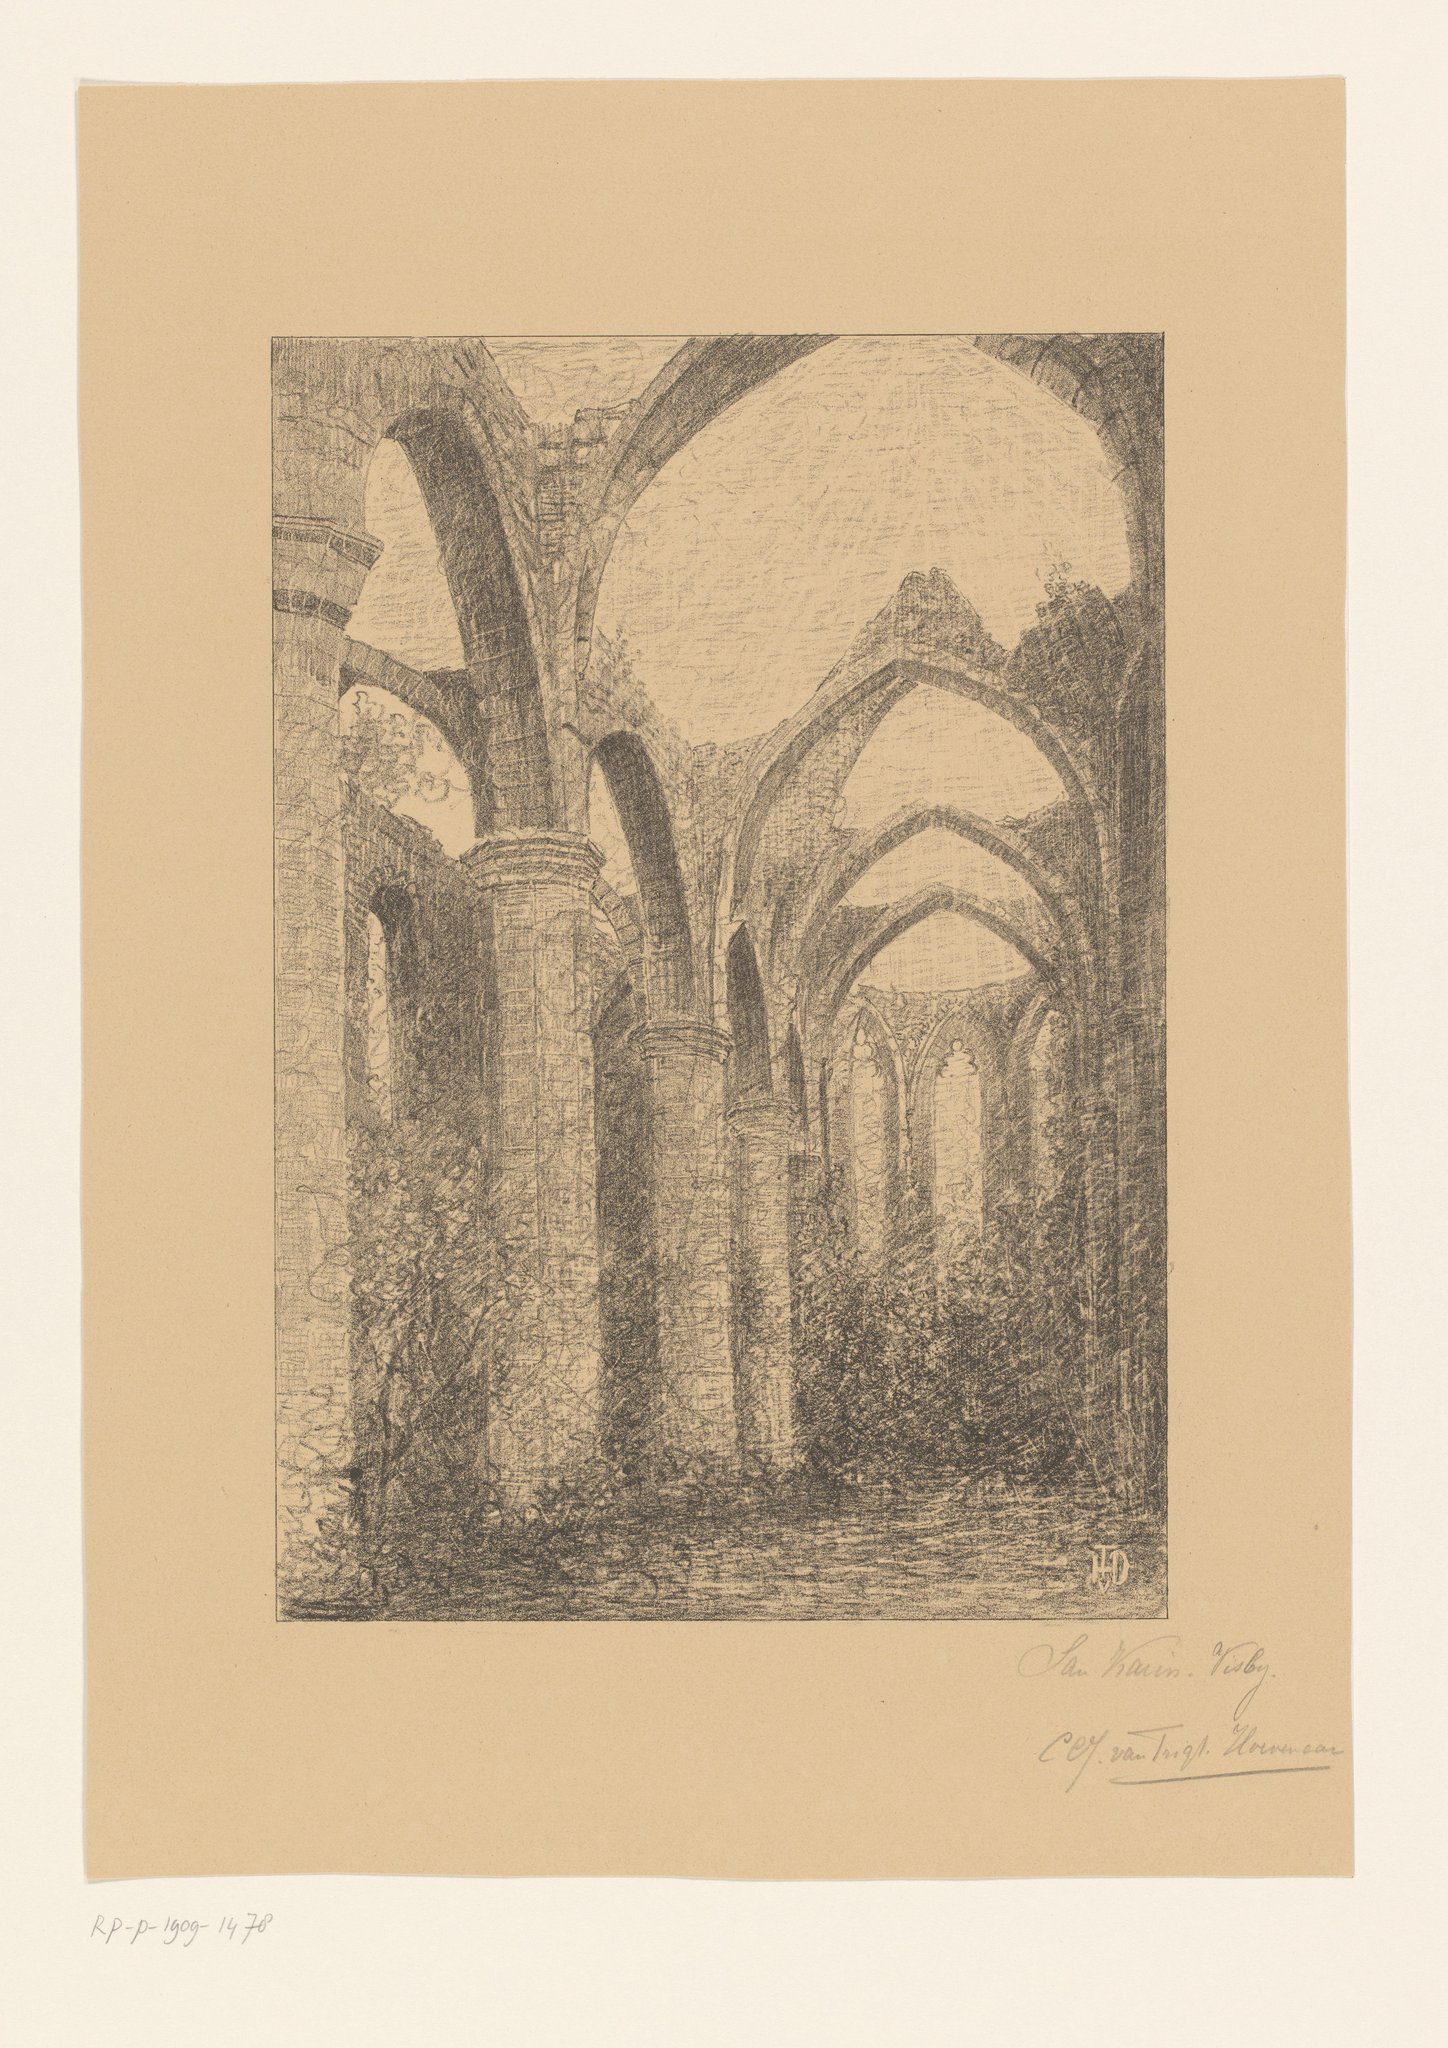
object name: print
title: Ruïne van San Karin op Visby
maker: cornelia christina johanna van trigt-hoevenaar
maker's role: print maker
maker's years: 1854-1924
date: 1864-1909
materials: paper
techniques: lithograph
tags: ruin of church, monastery, etc.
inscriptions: collector's mark: Lugt 2228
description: Zicht op het koor en een zijbeuk vanuit het overwoekerde middenschip waarvan het dak ontbreekt.